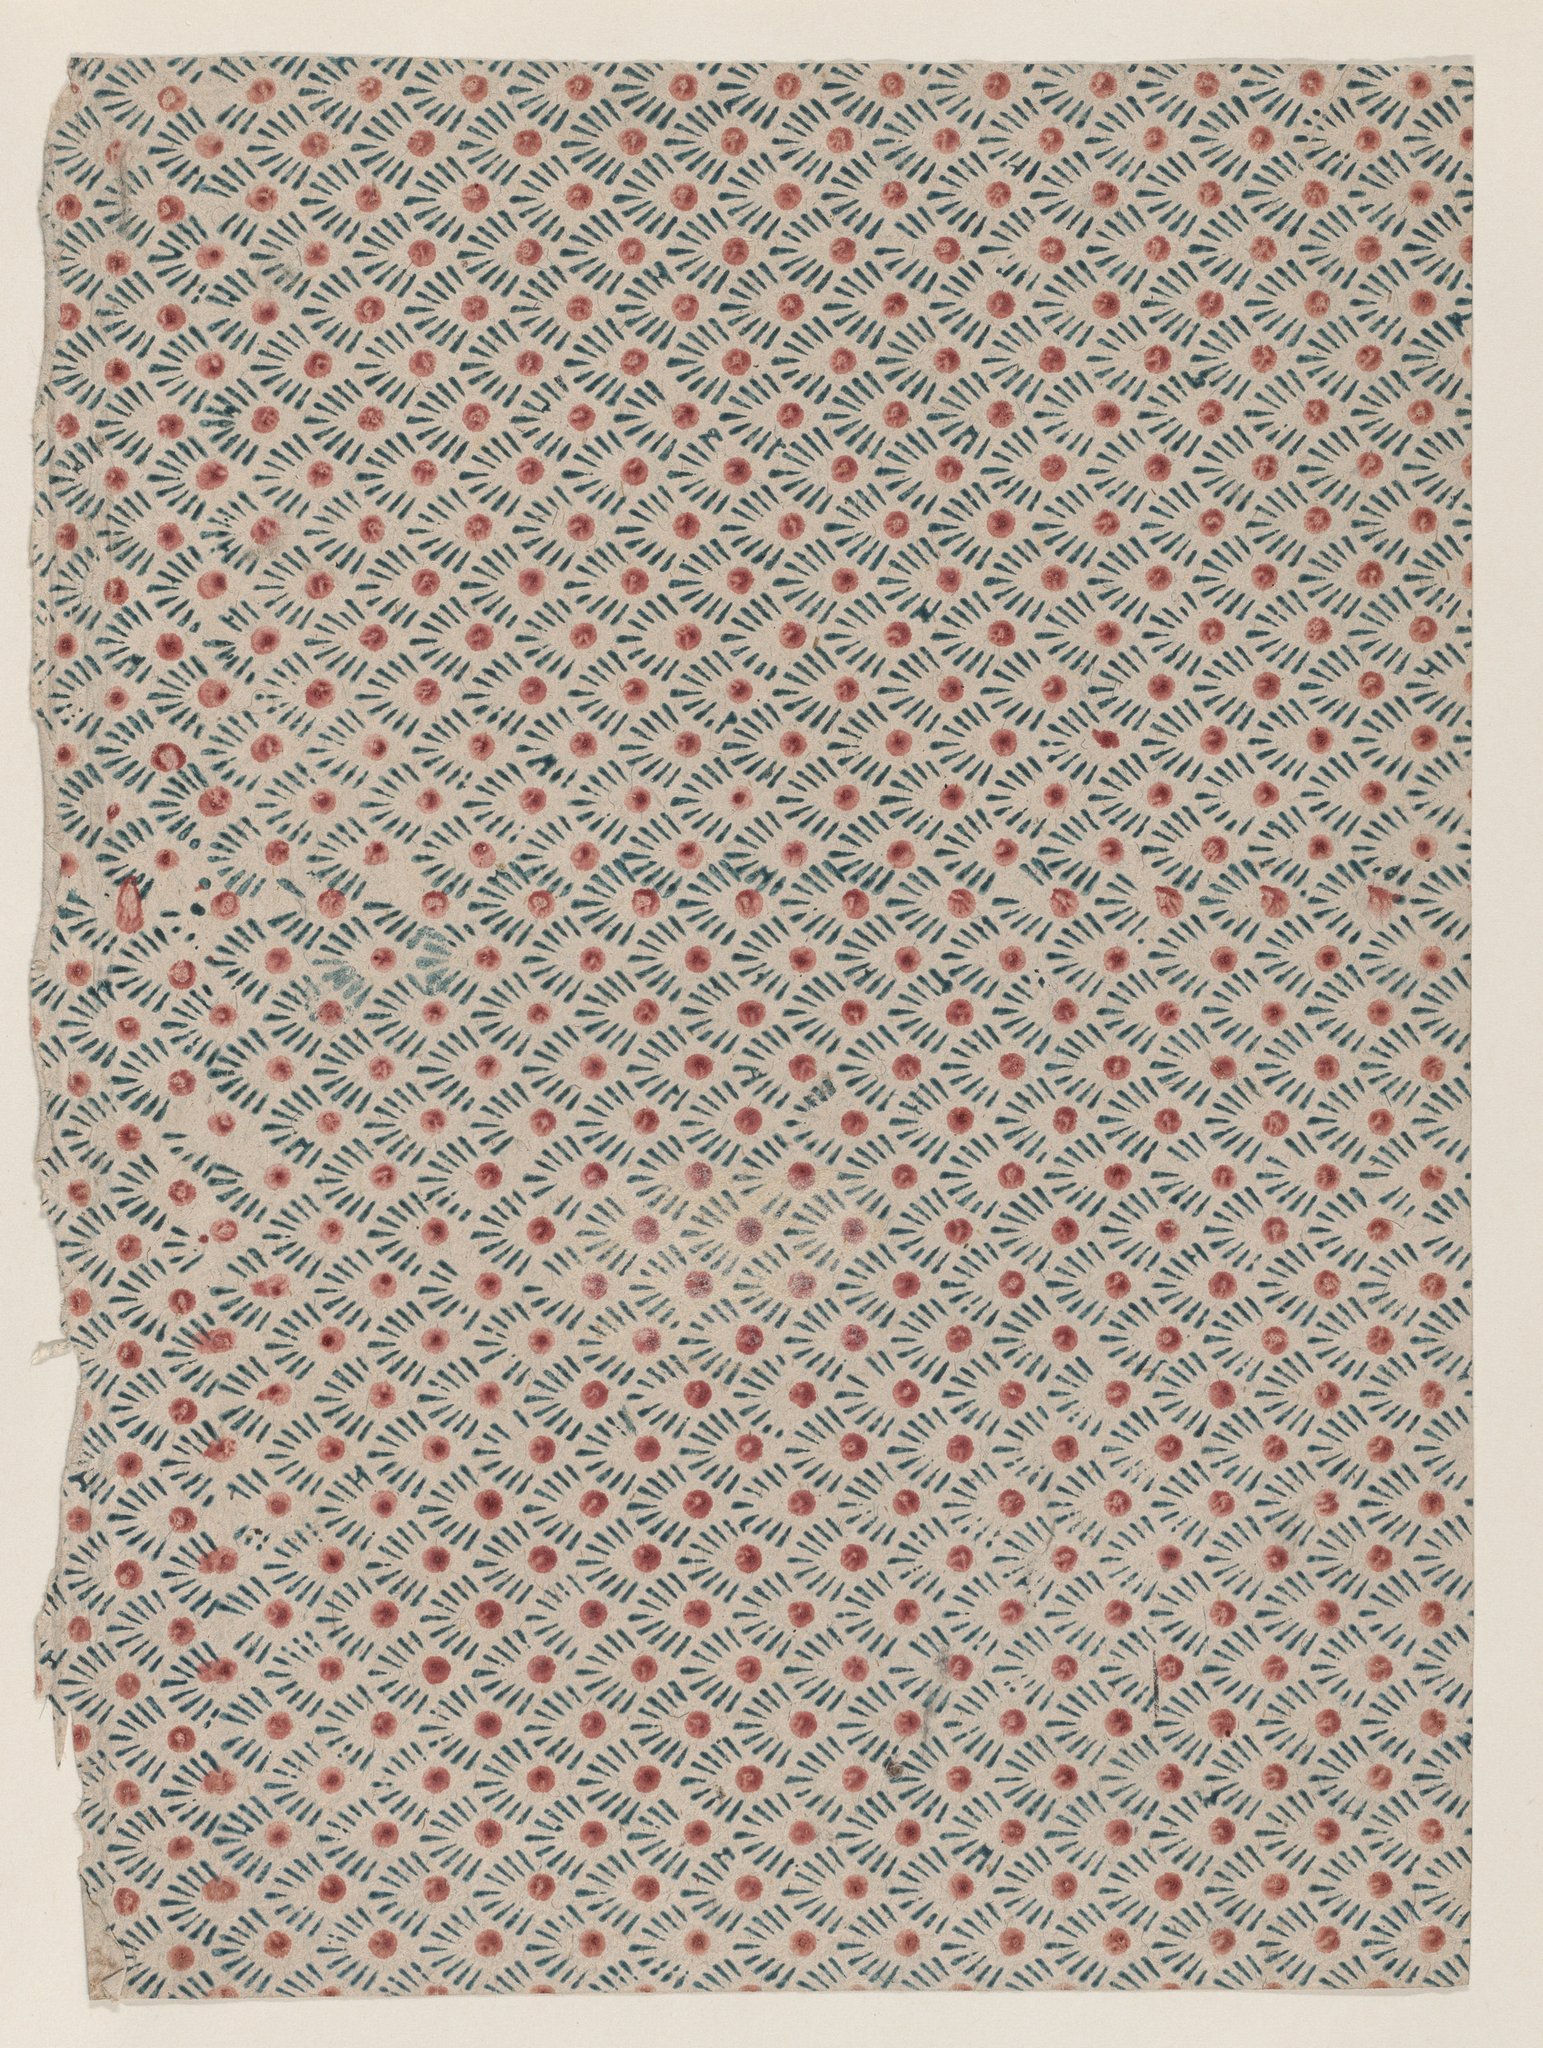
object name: print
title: Sheet with overall dot and line pattern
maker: Anonymous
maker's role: artist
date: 1801-1900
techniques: relief print